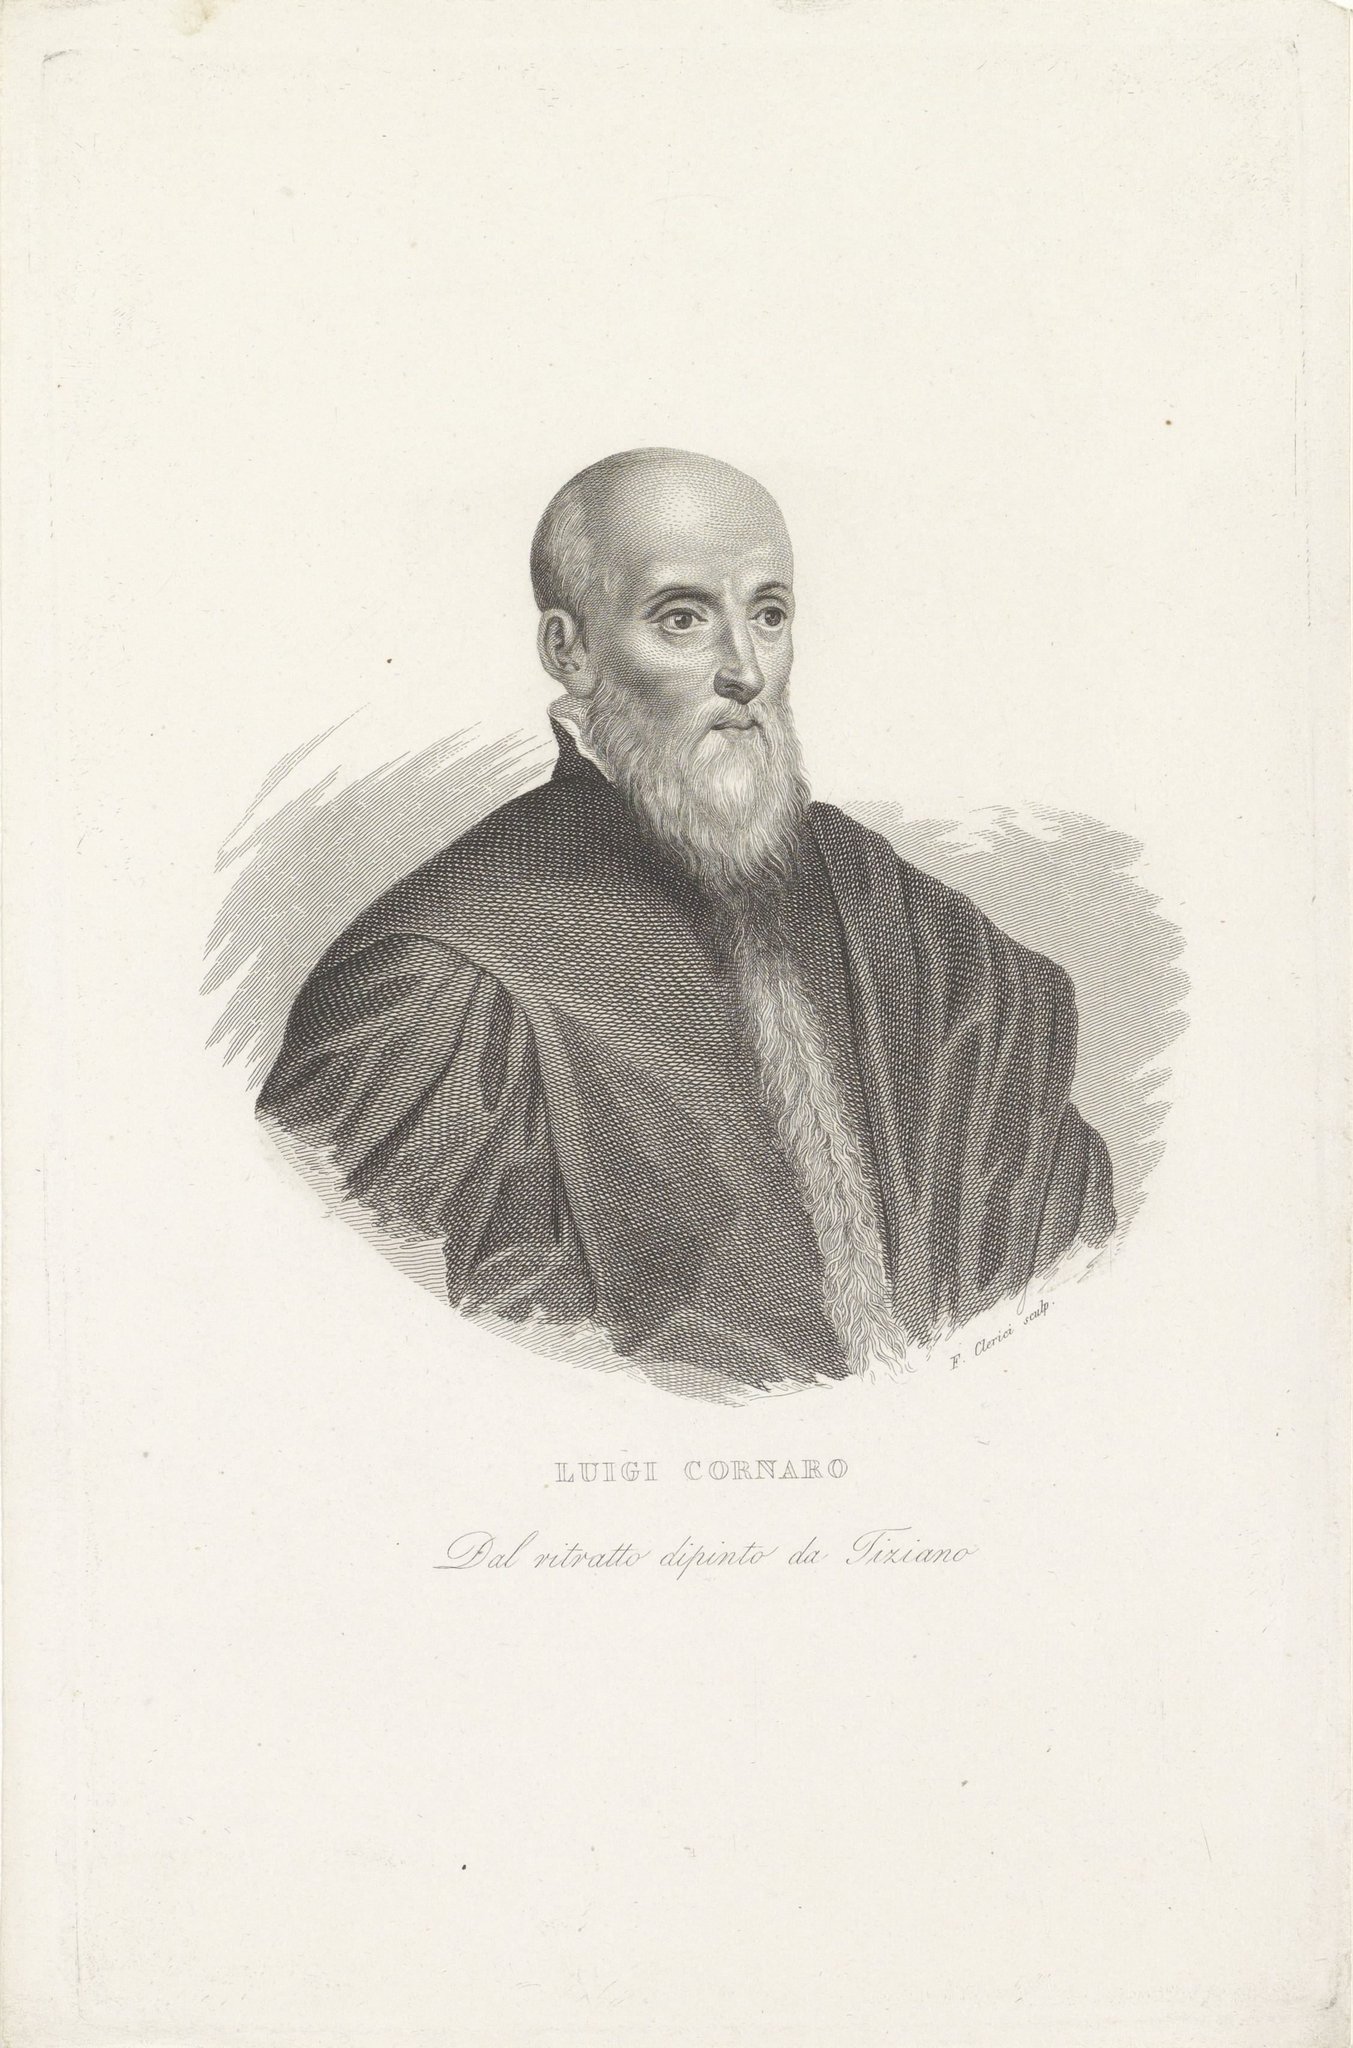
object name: print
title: Portret van schrijver en mecenas Alvise Corner (Luigi Cornaro)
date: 1855-1865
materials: paper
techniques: engraving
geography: italy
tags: venice, alvise corner, historical persons, portrait of a writer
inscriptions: collector's mark: Lugt 2228